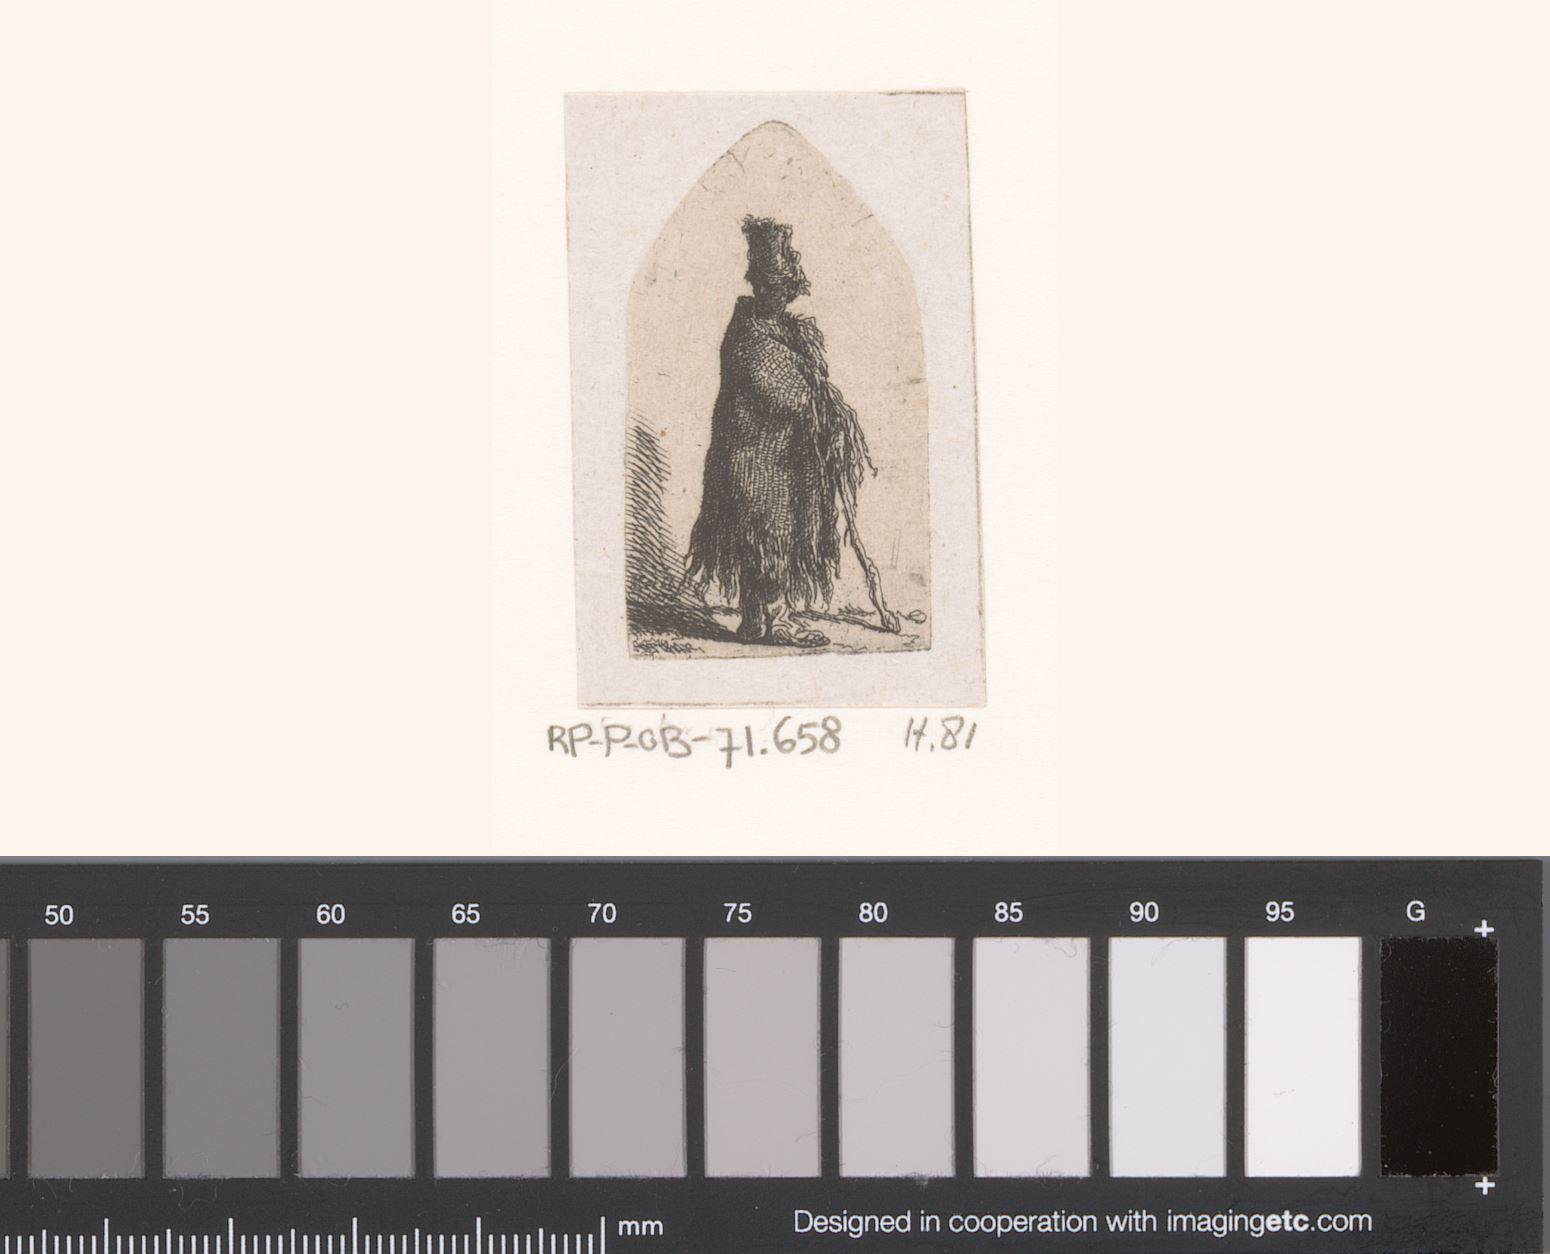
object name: print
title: Man in een lange mantel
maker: jean pierre norblin de la gourdaine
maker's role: print maker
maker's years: 1745-1830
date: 1778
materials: paper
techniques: etching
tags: coat, cape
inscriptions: date